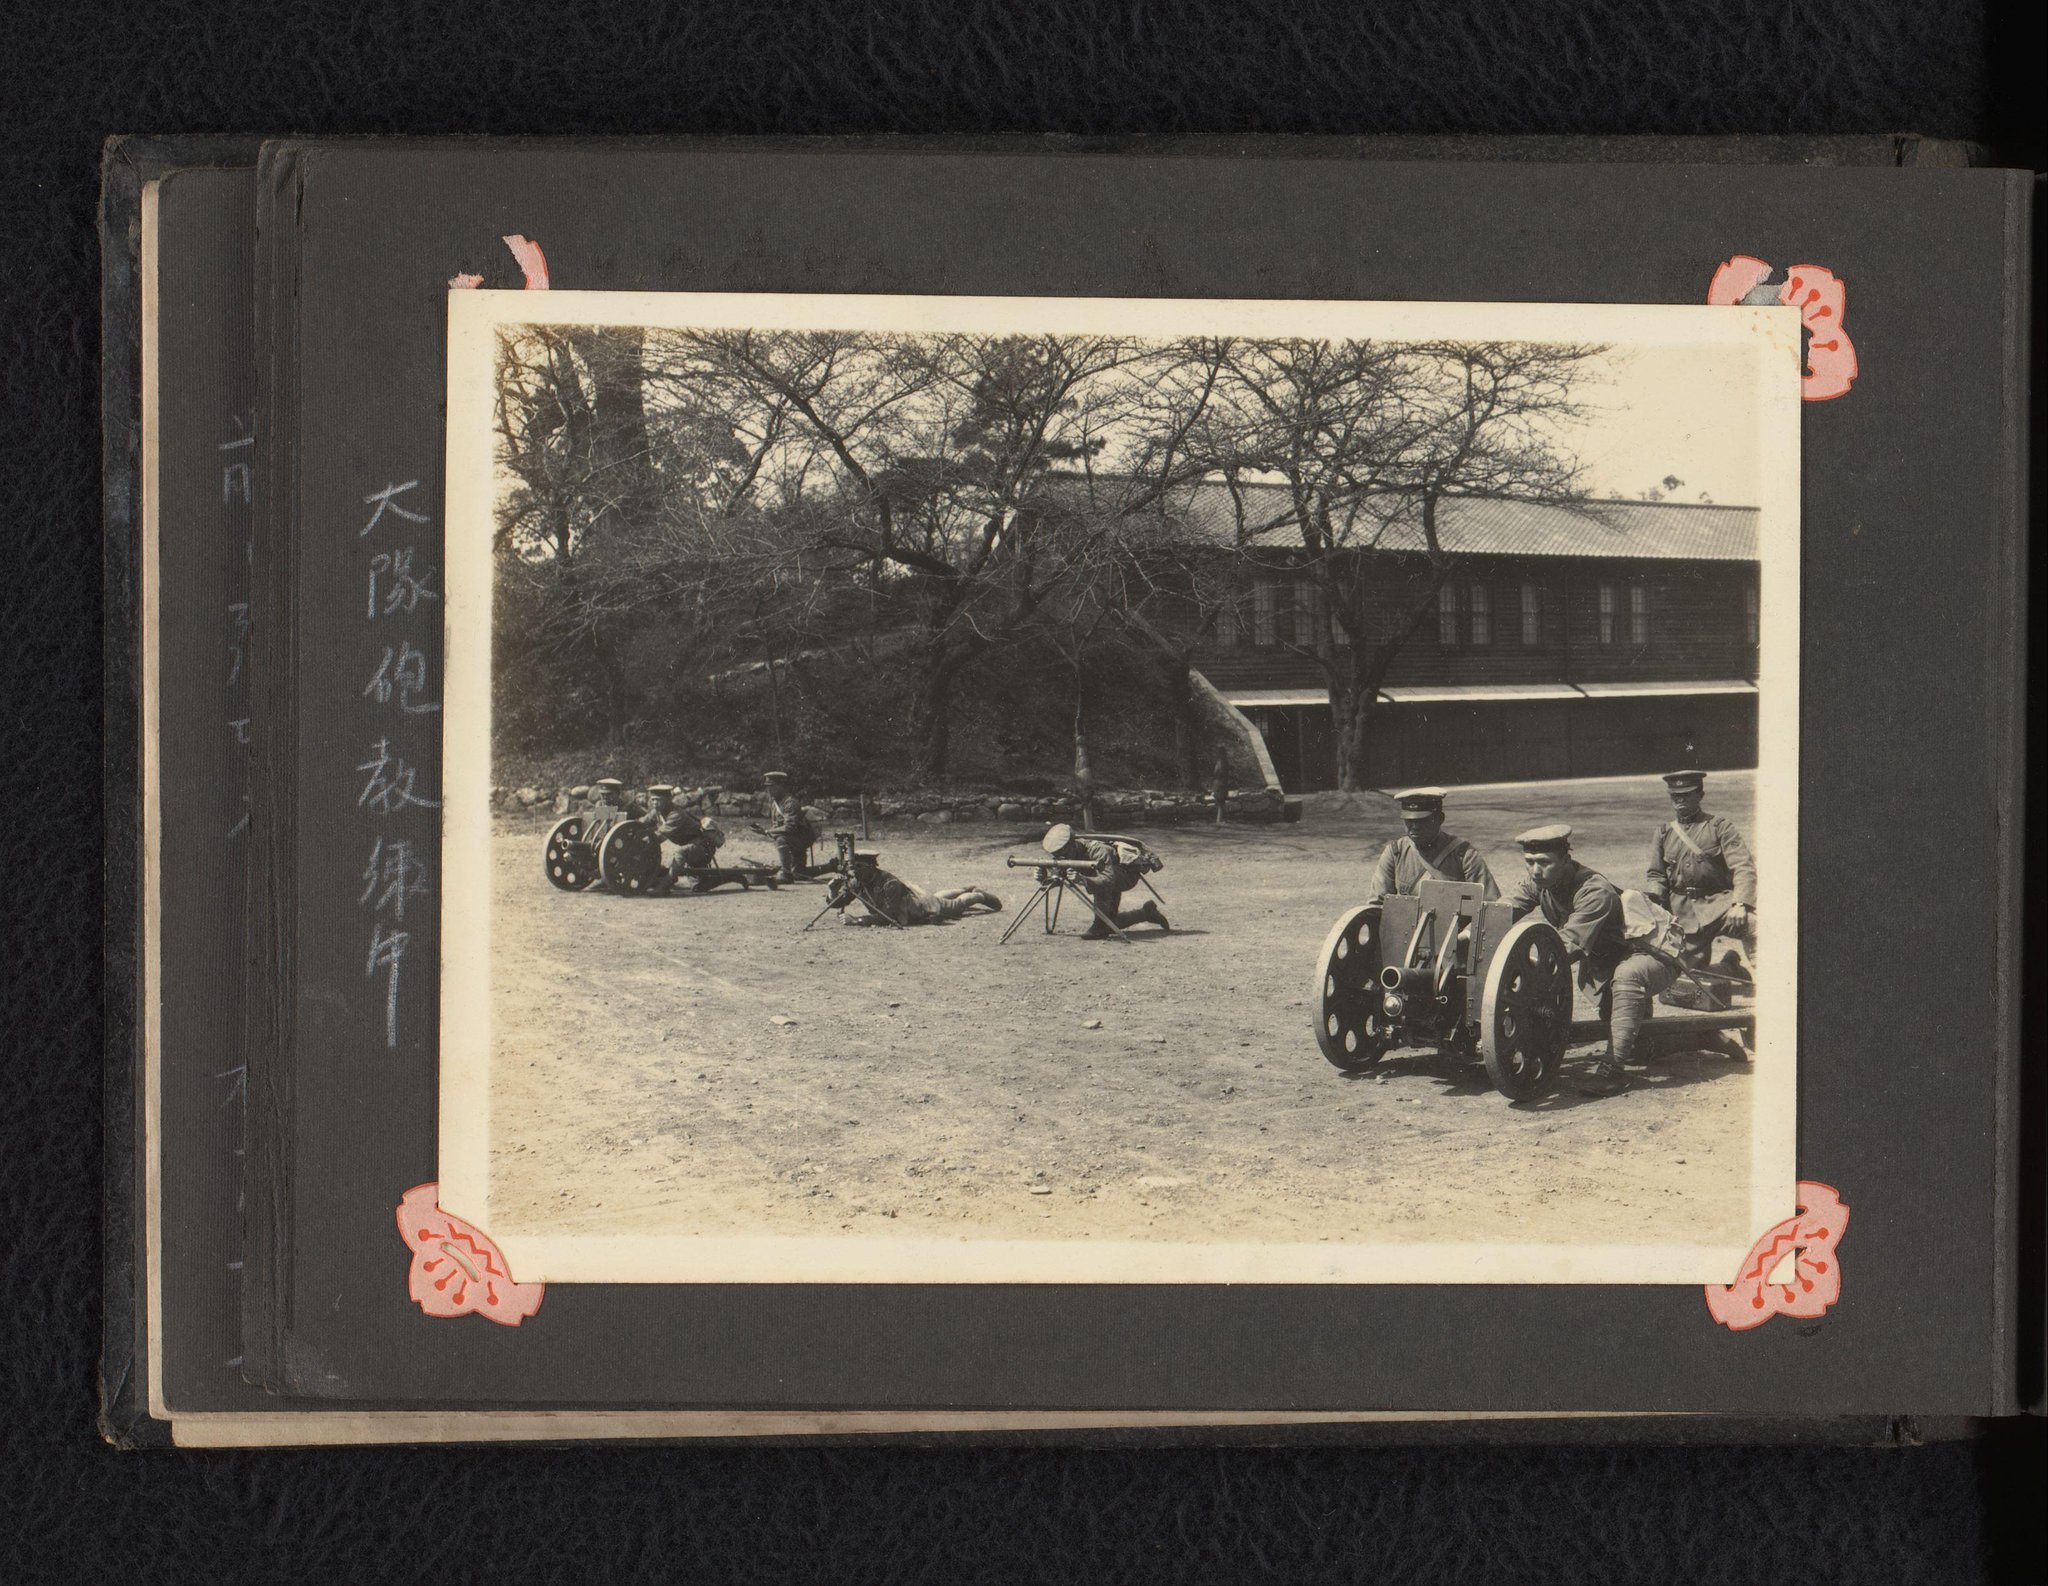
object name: album leaf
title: Japanse soldaten met militair geschut, vermoedelijk bij een legerbasis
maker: Anonymous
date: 1937-1941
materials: paper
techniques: gelatin silver print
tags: the soldier; the soldier's life, projectiles, explosives, etc.